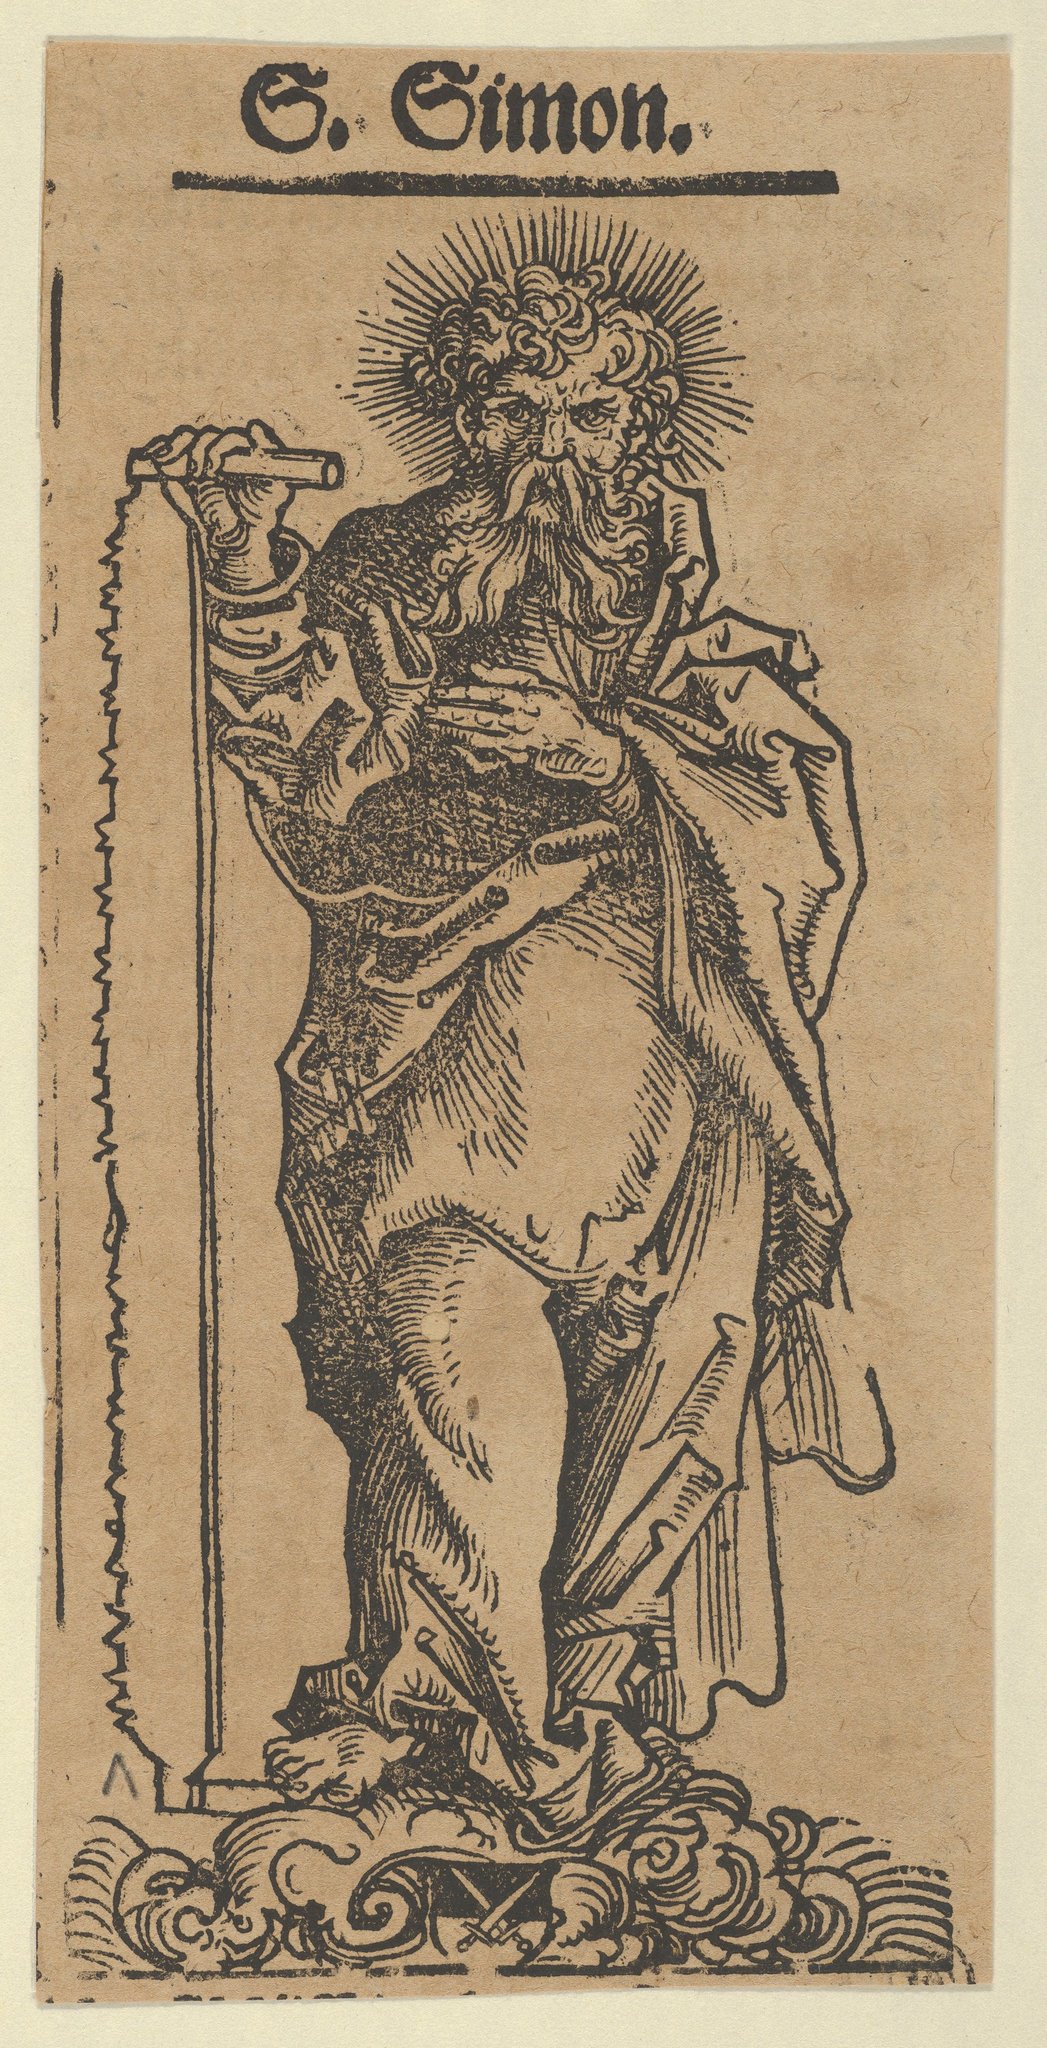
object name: print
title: Silver Statuette of St. Simon, from the "Wittenberg Reliquaries"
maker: lucas cranach the elder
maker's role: artist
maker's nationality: german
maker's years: 1472-1553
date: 1472-1553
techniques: woodcut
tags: men,saints